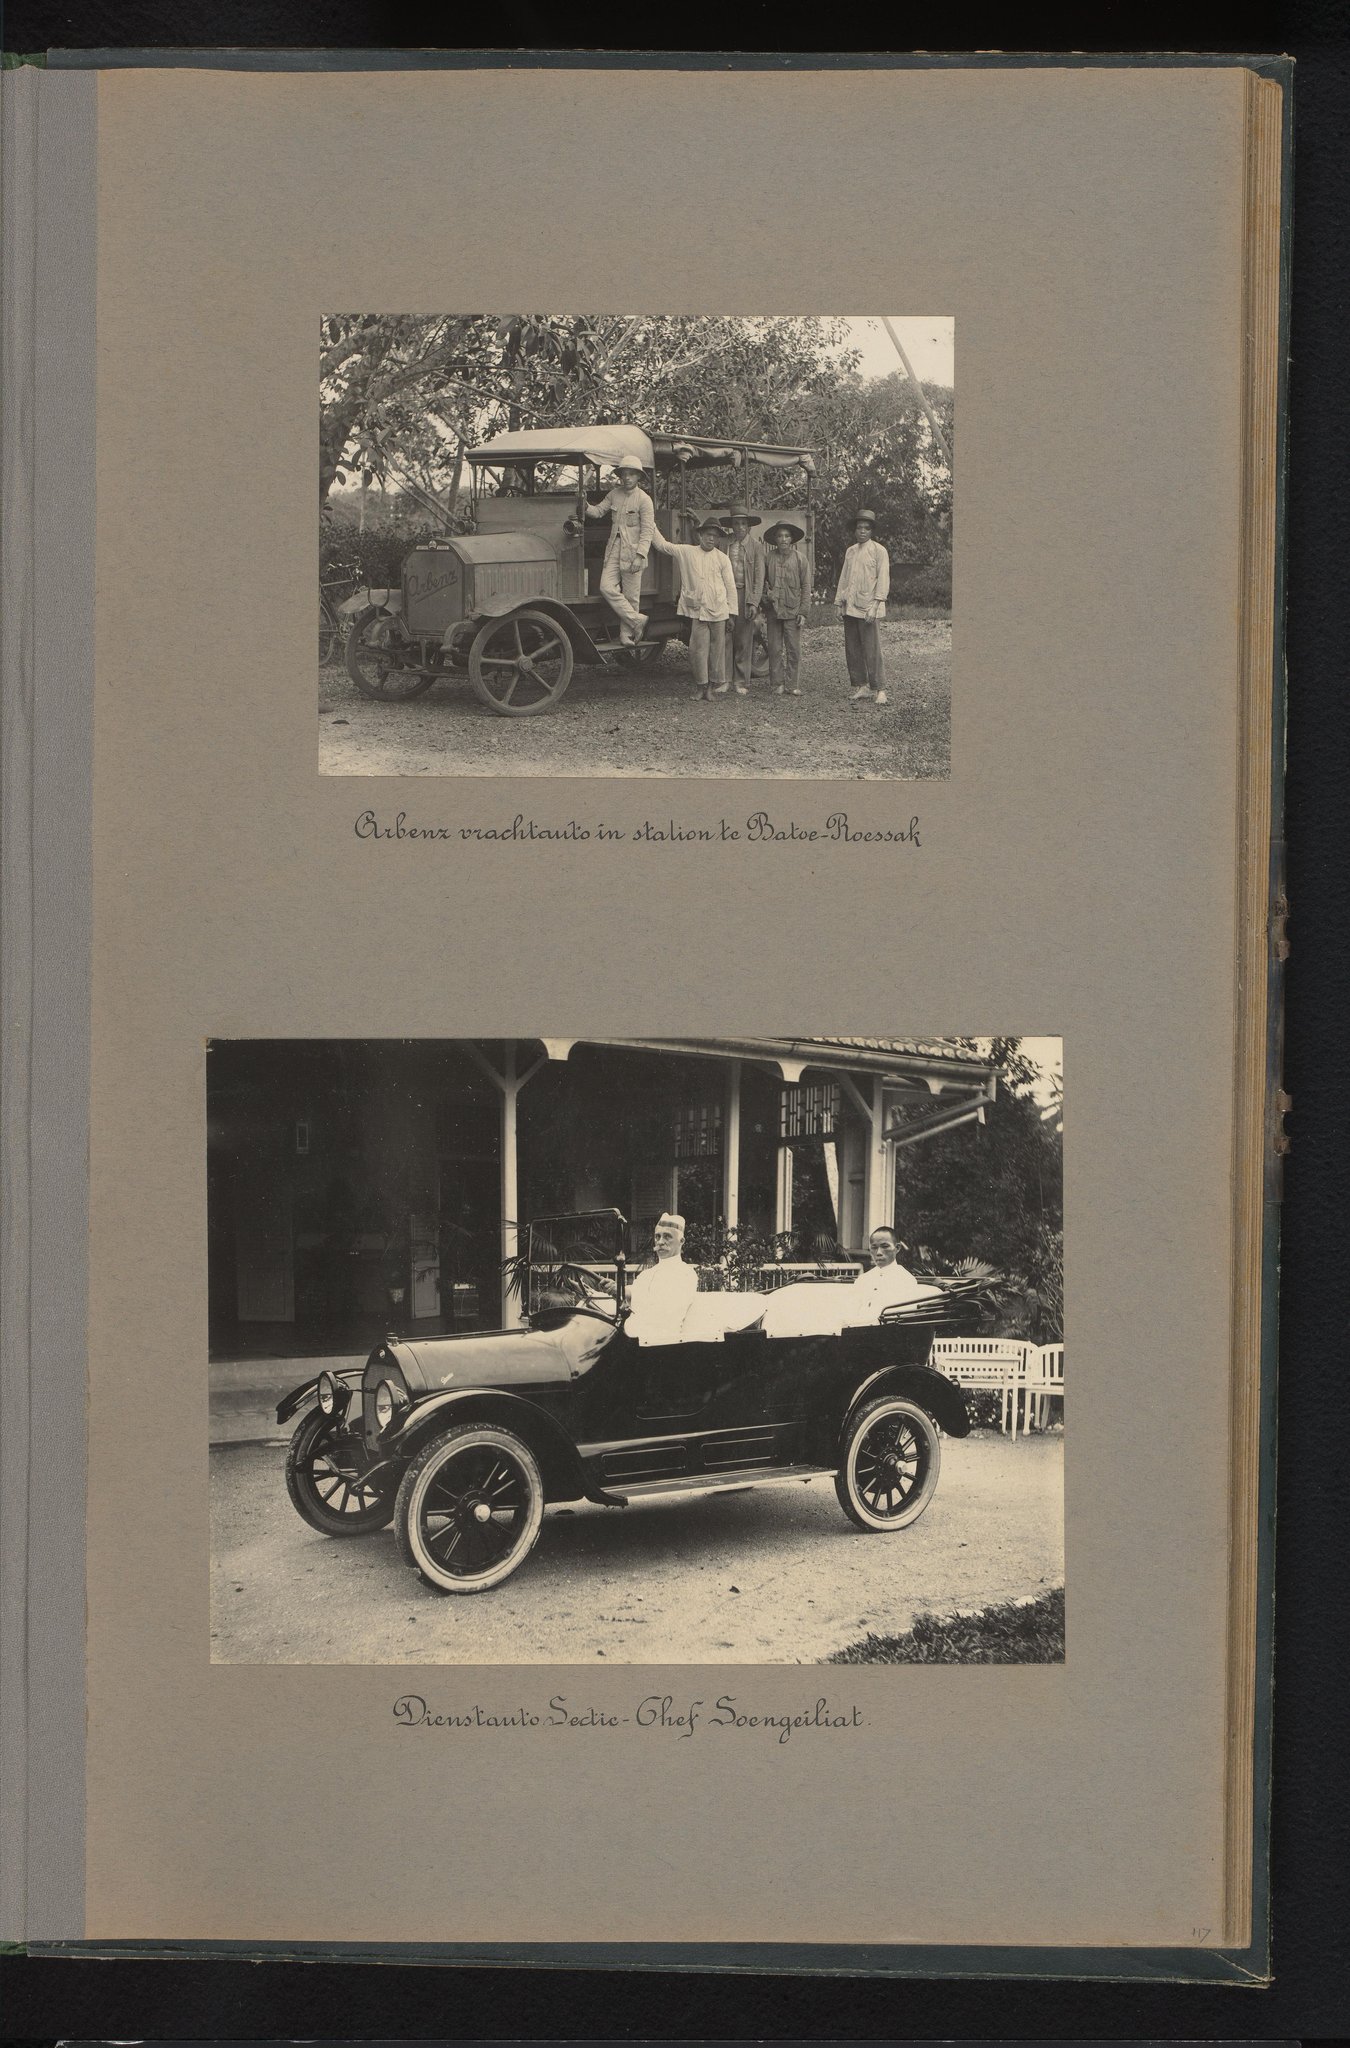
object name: photograph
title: Vracht- en dienstauto van de Banka-tinwinning te Soengeiliat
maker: Anonymous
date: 1914-1919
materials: cardboard, photographic support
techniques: gelatin silver print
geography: bangka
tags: robert julius boers, truck, van, colonial system, mining, automobile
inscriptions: inscription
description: Albumblad met 2 foto's van een Arbenz vrachtauto en de dienstauto met chauffeur van de Banka-tinwinning te Soengeiliat. Onderdeel van het fotoalbum aangeboden aan Robert Julius Boers bij zijn vertrek naar Nederland in 1919 door het personeel van de Banka-tinwinning.